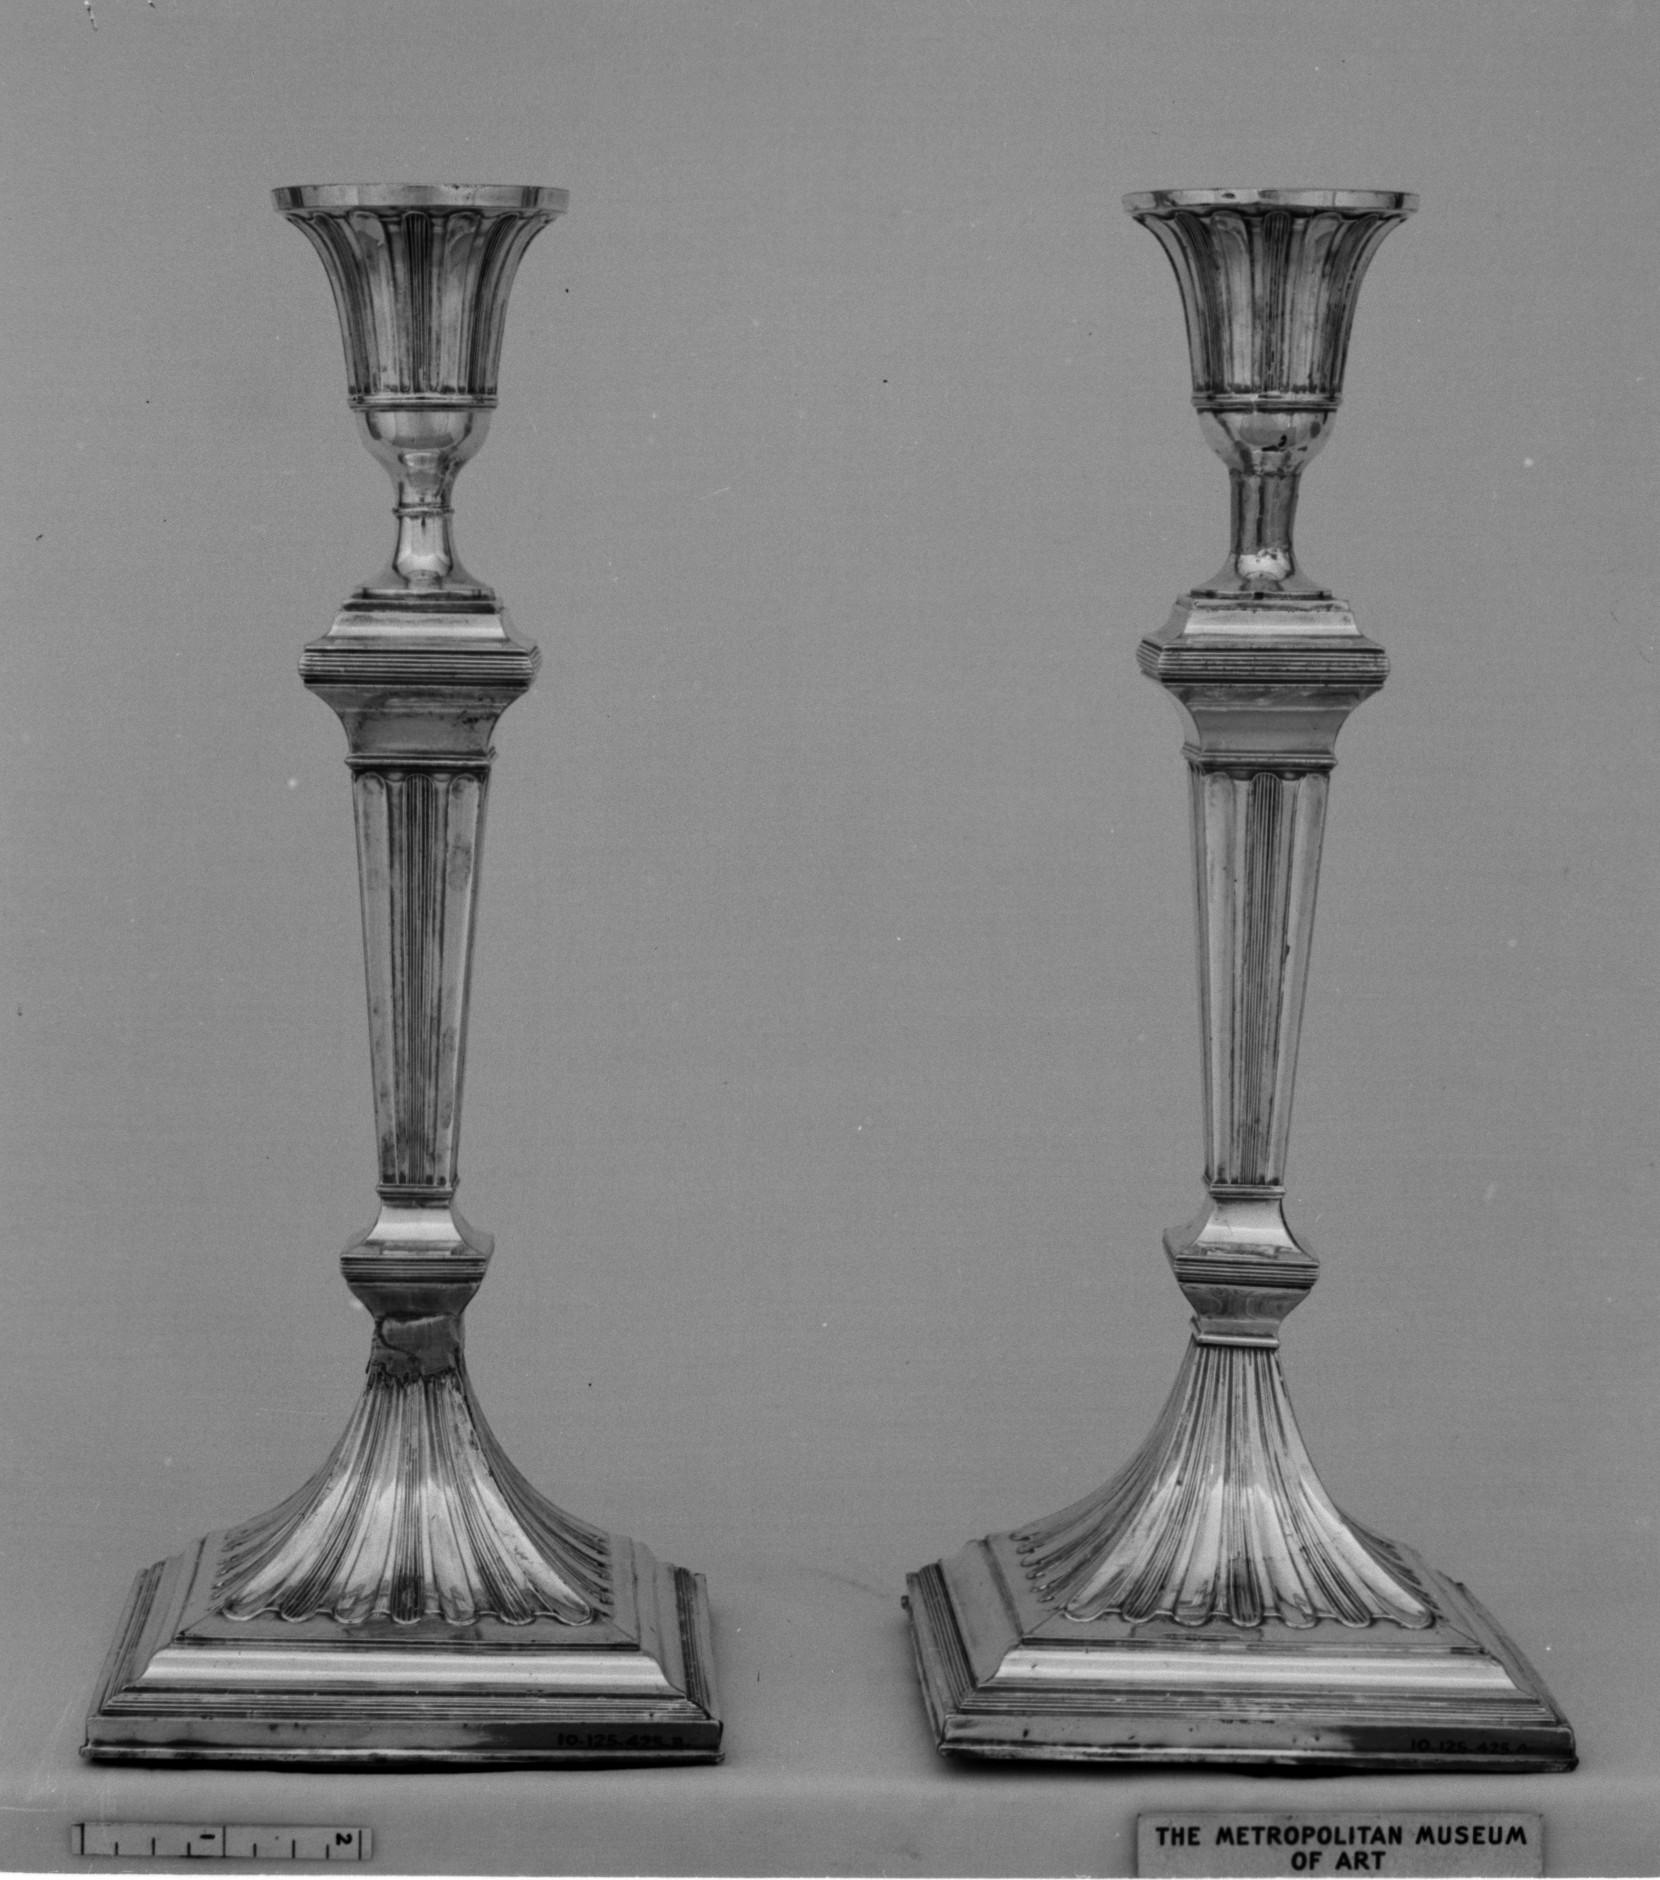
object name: candlestick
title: Pair of candlesticks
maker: john parsons & co.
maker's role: maker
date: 1785-1790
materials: metal